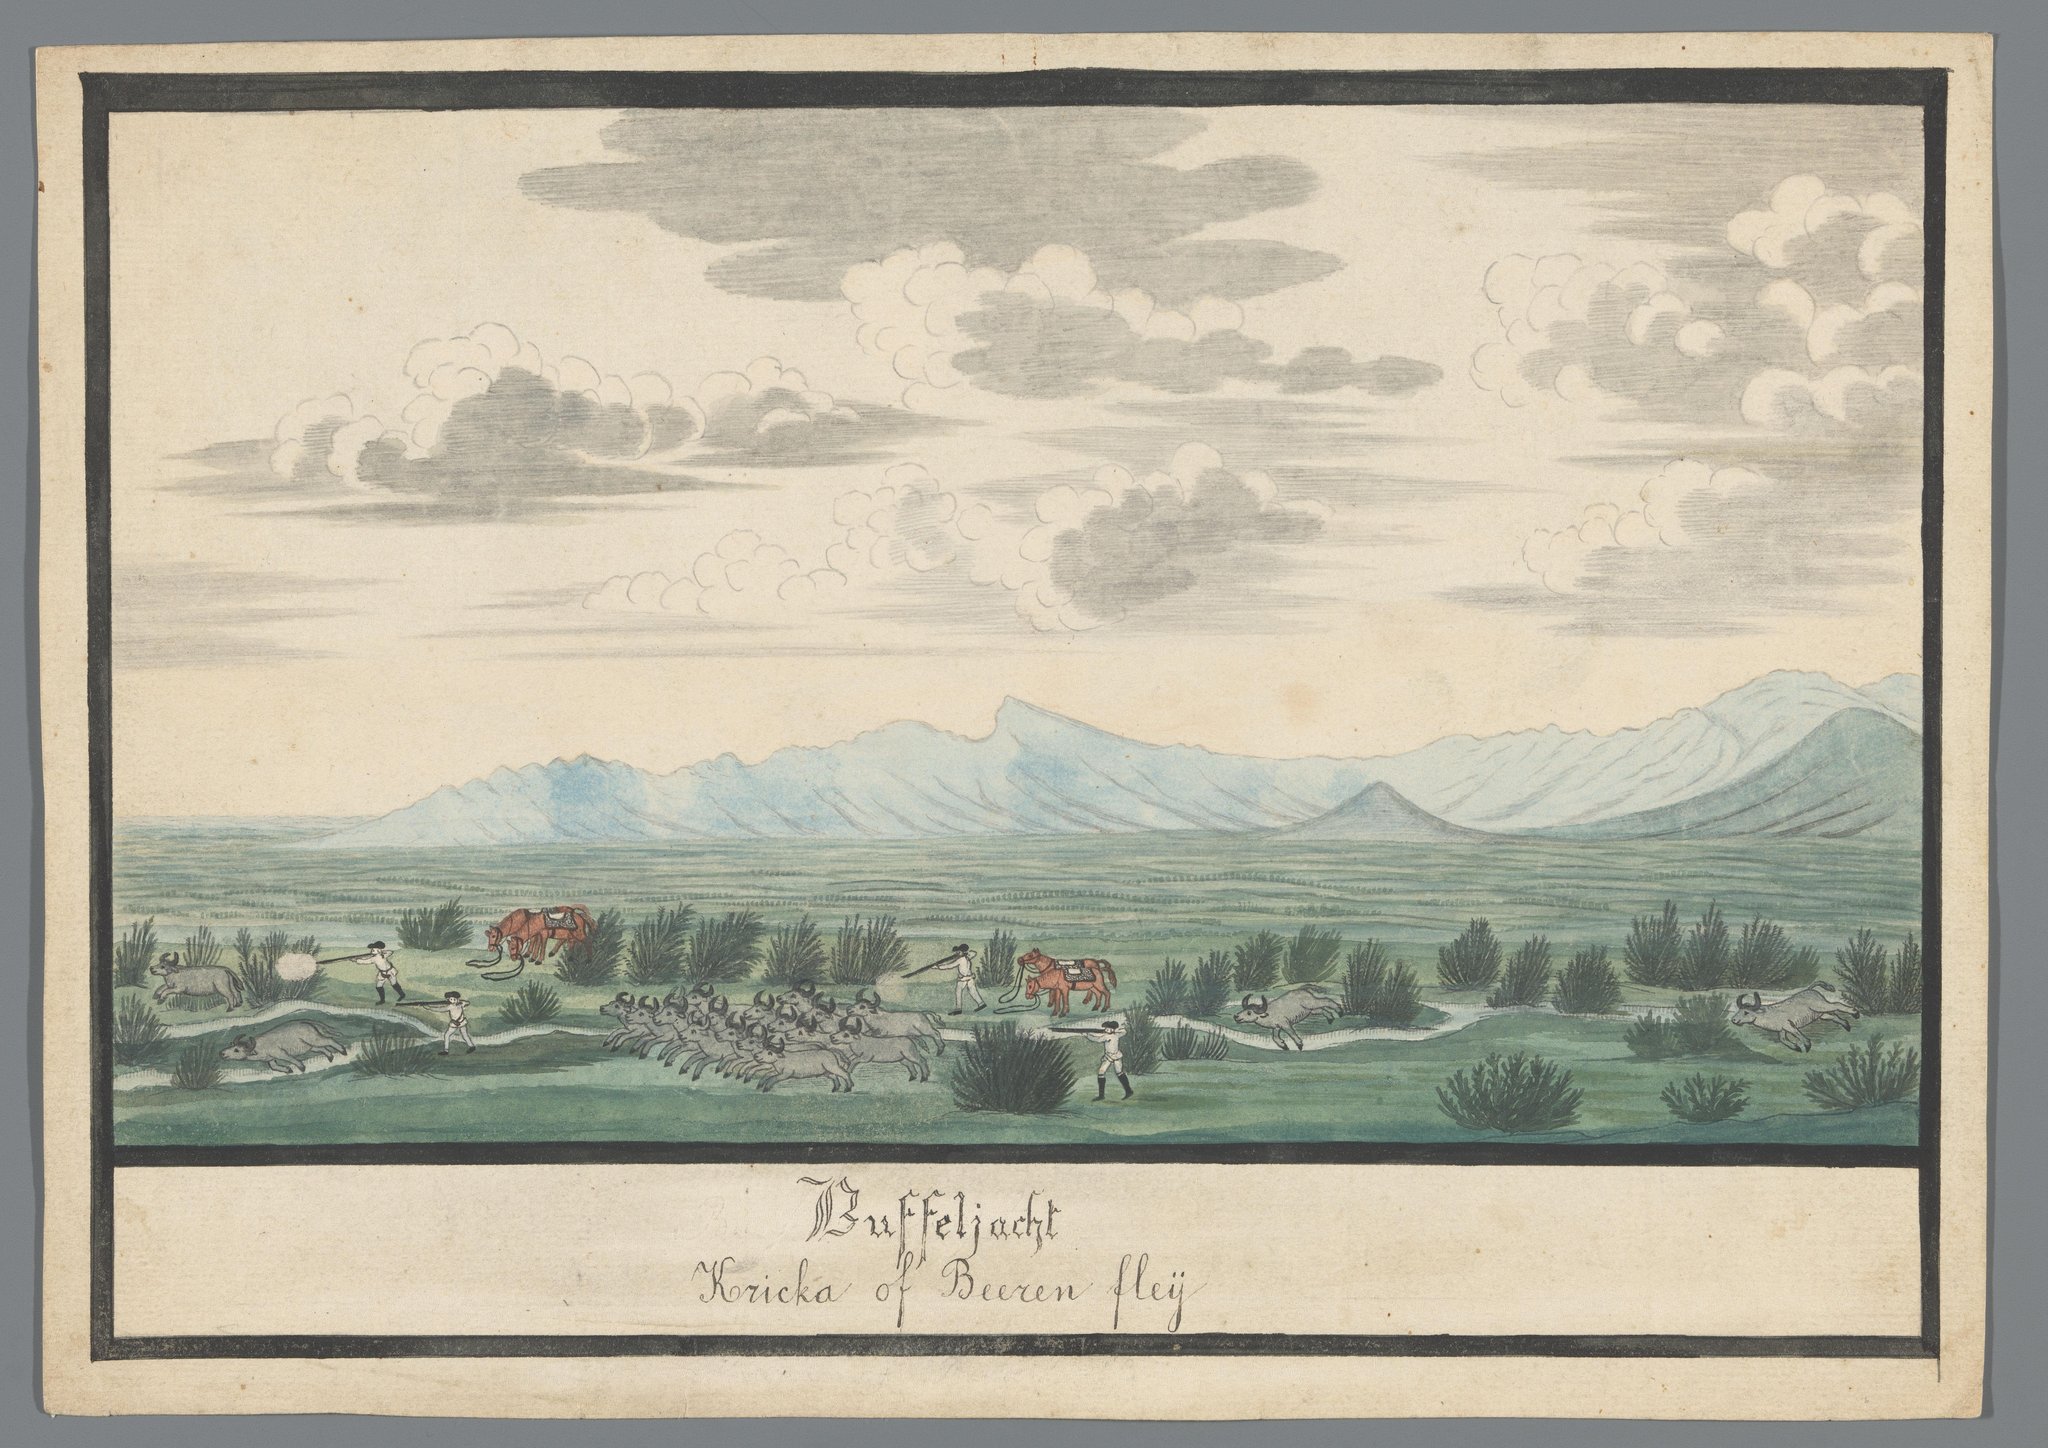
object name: drawing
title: Aquarellen betrekking hebbende op de drie reizen door de Kaap door Hendrik Swellengrebel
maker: johannes schumacher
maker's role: draughtsman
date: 1710-1776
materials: paper, watercolor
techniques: brush, pen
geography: south africa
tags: hoofed animals: buffalo, hunt ~ hoofed animals, mountain-range, snow peaks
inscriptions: label: ‘42’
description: Jacht op buffels, in de vallei van de Kariega (Cricka) rivier of Beervlei. Tekening gemaakt tijdens de tweede reis van Hendrik Swellengrebel, naar het noordoosten van de Kaapkolonie, 10 september - 26 december 1776. Volgens het reisjournaal werd op 5 oktober 1776 door het reisgezelschap hier gejaagd op buffels.